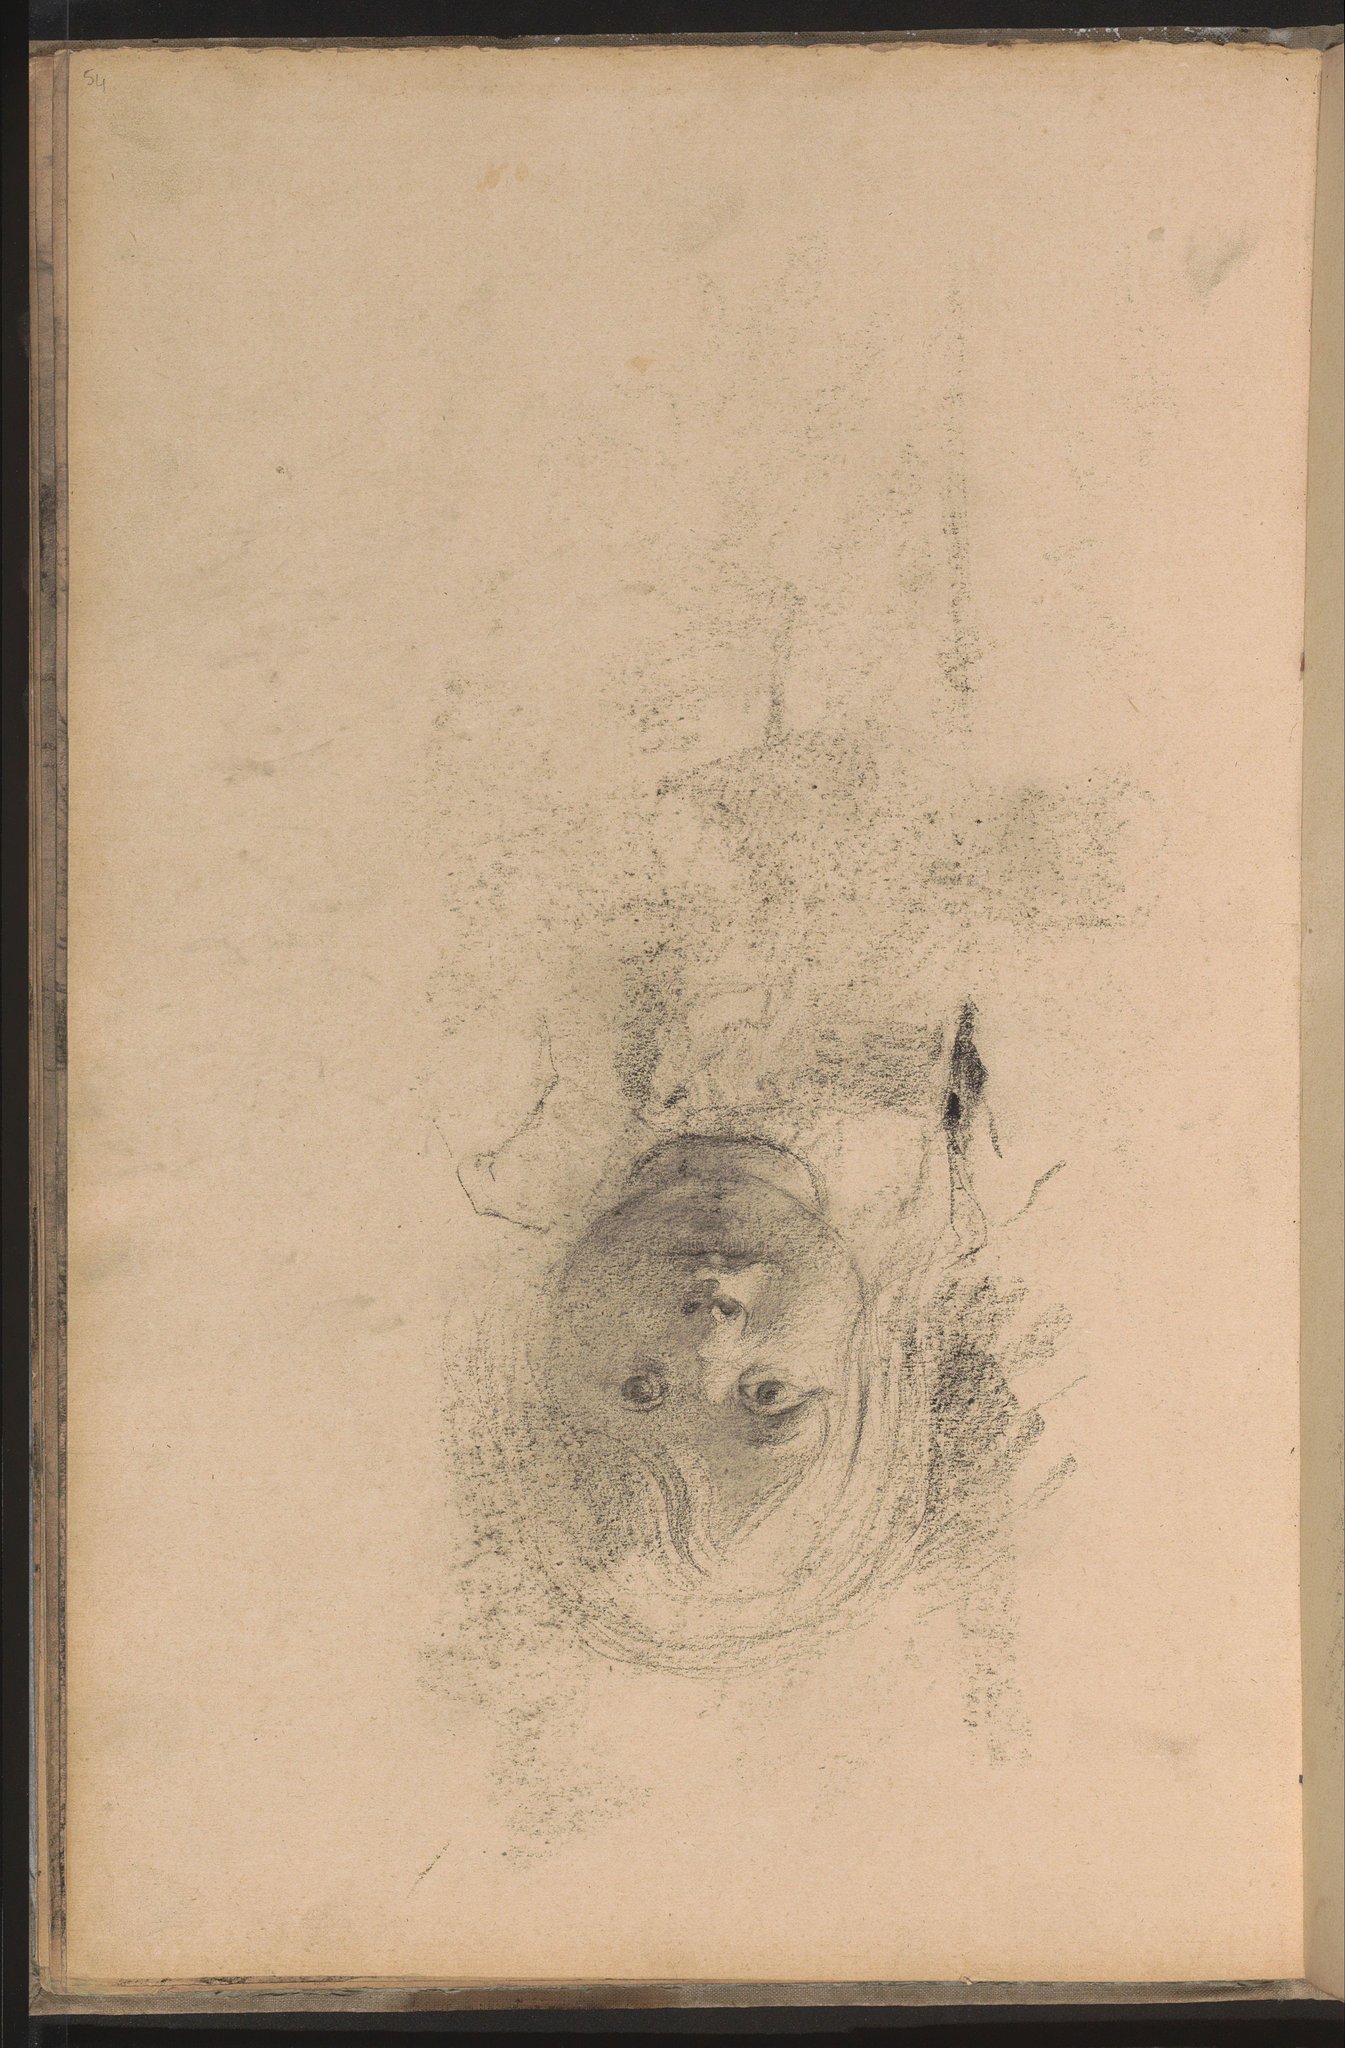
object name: sketchbook leaf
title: Hoofd van een meisje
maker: willem witsen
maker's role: draughtsman, painter, print maker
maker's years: 1860-1923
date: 1884-1887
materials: chalk, paper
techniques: stumping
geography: ewijkshoeve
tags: girl (child between toddler and youth), head (human) - aa - female human figure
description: Pagina 54 uit een schetsboek met 45 bladen vervaardigd rond de Ewijkshoeve.